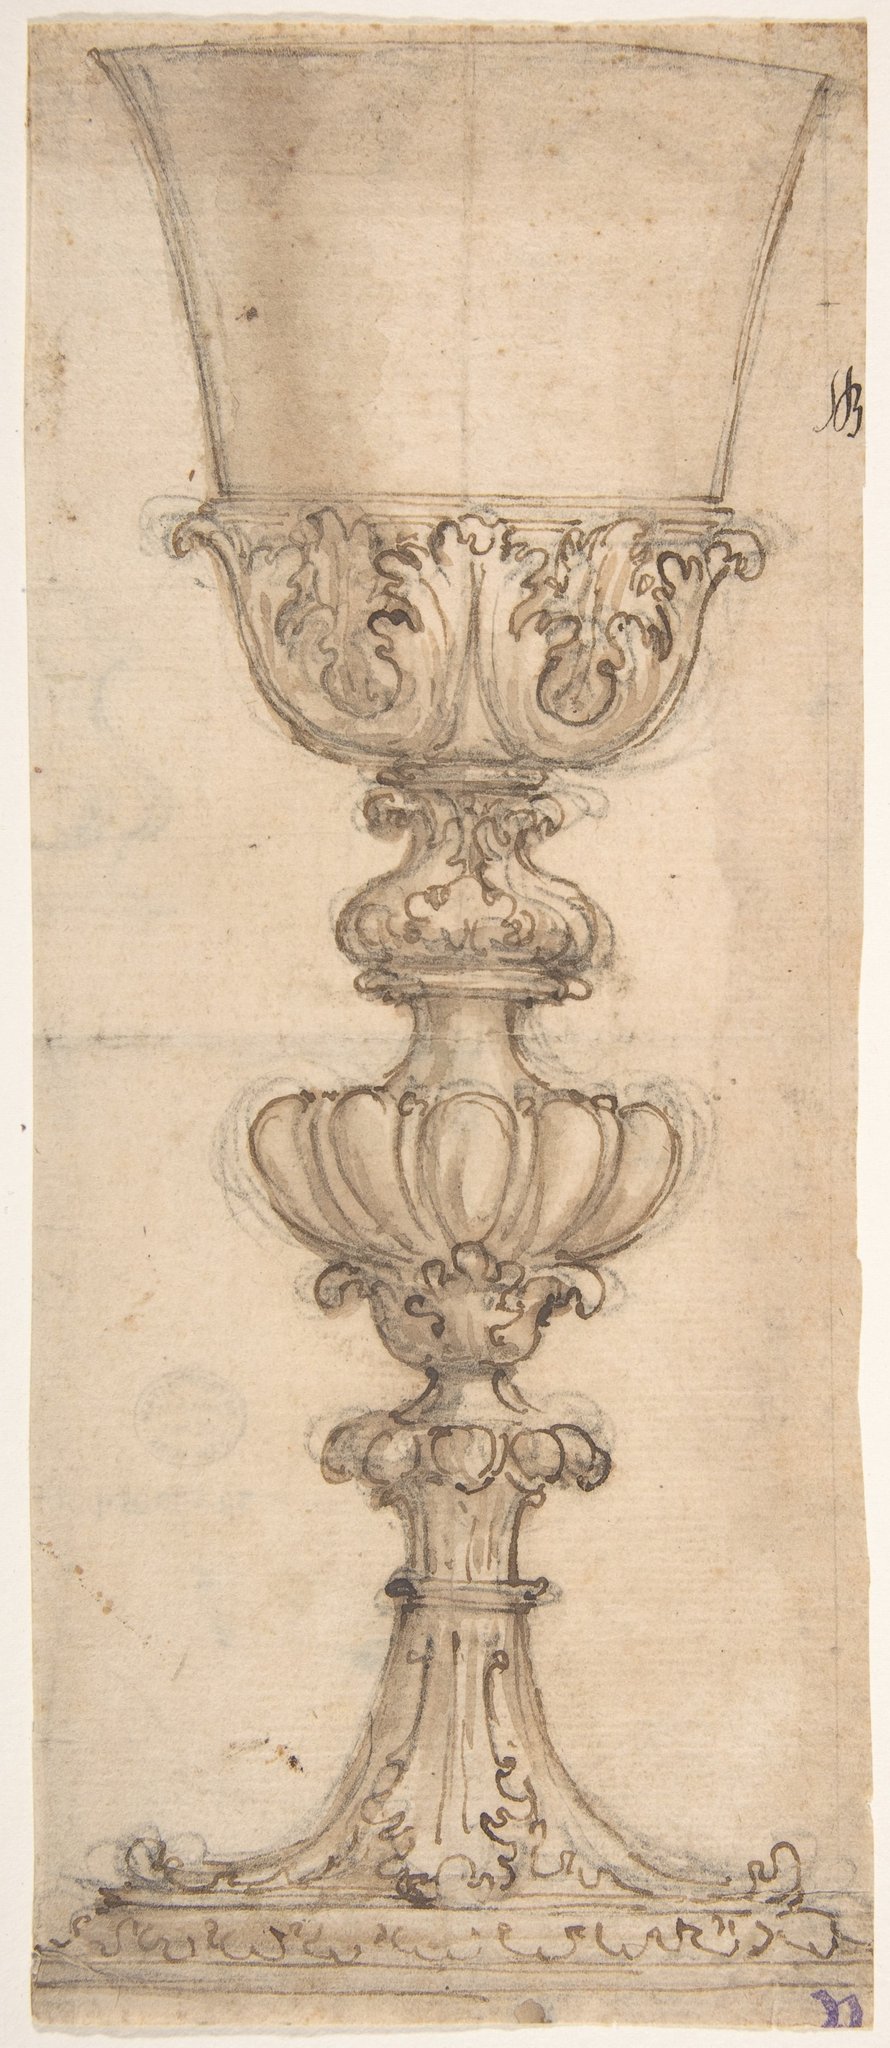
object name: drawing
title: Design for a Chalice (recto); Design for the Base of a Vase (verso)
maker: giovanni battista foggini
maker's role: artist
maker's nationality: italian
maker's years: 1652-1725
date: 1672-1725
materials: chalk, graphite, ink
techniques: brush, pen, wash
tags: chalices